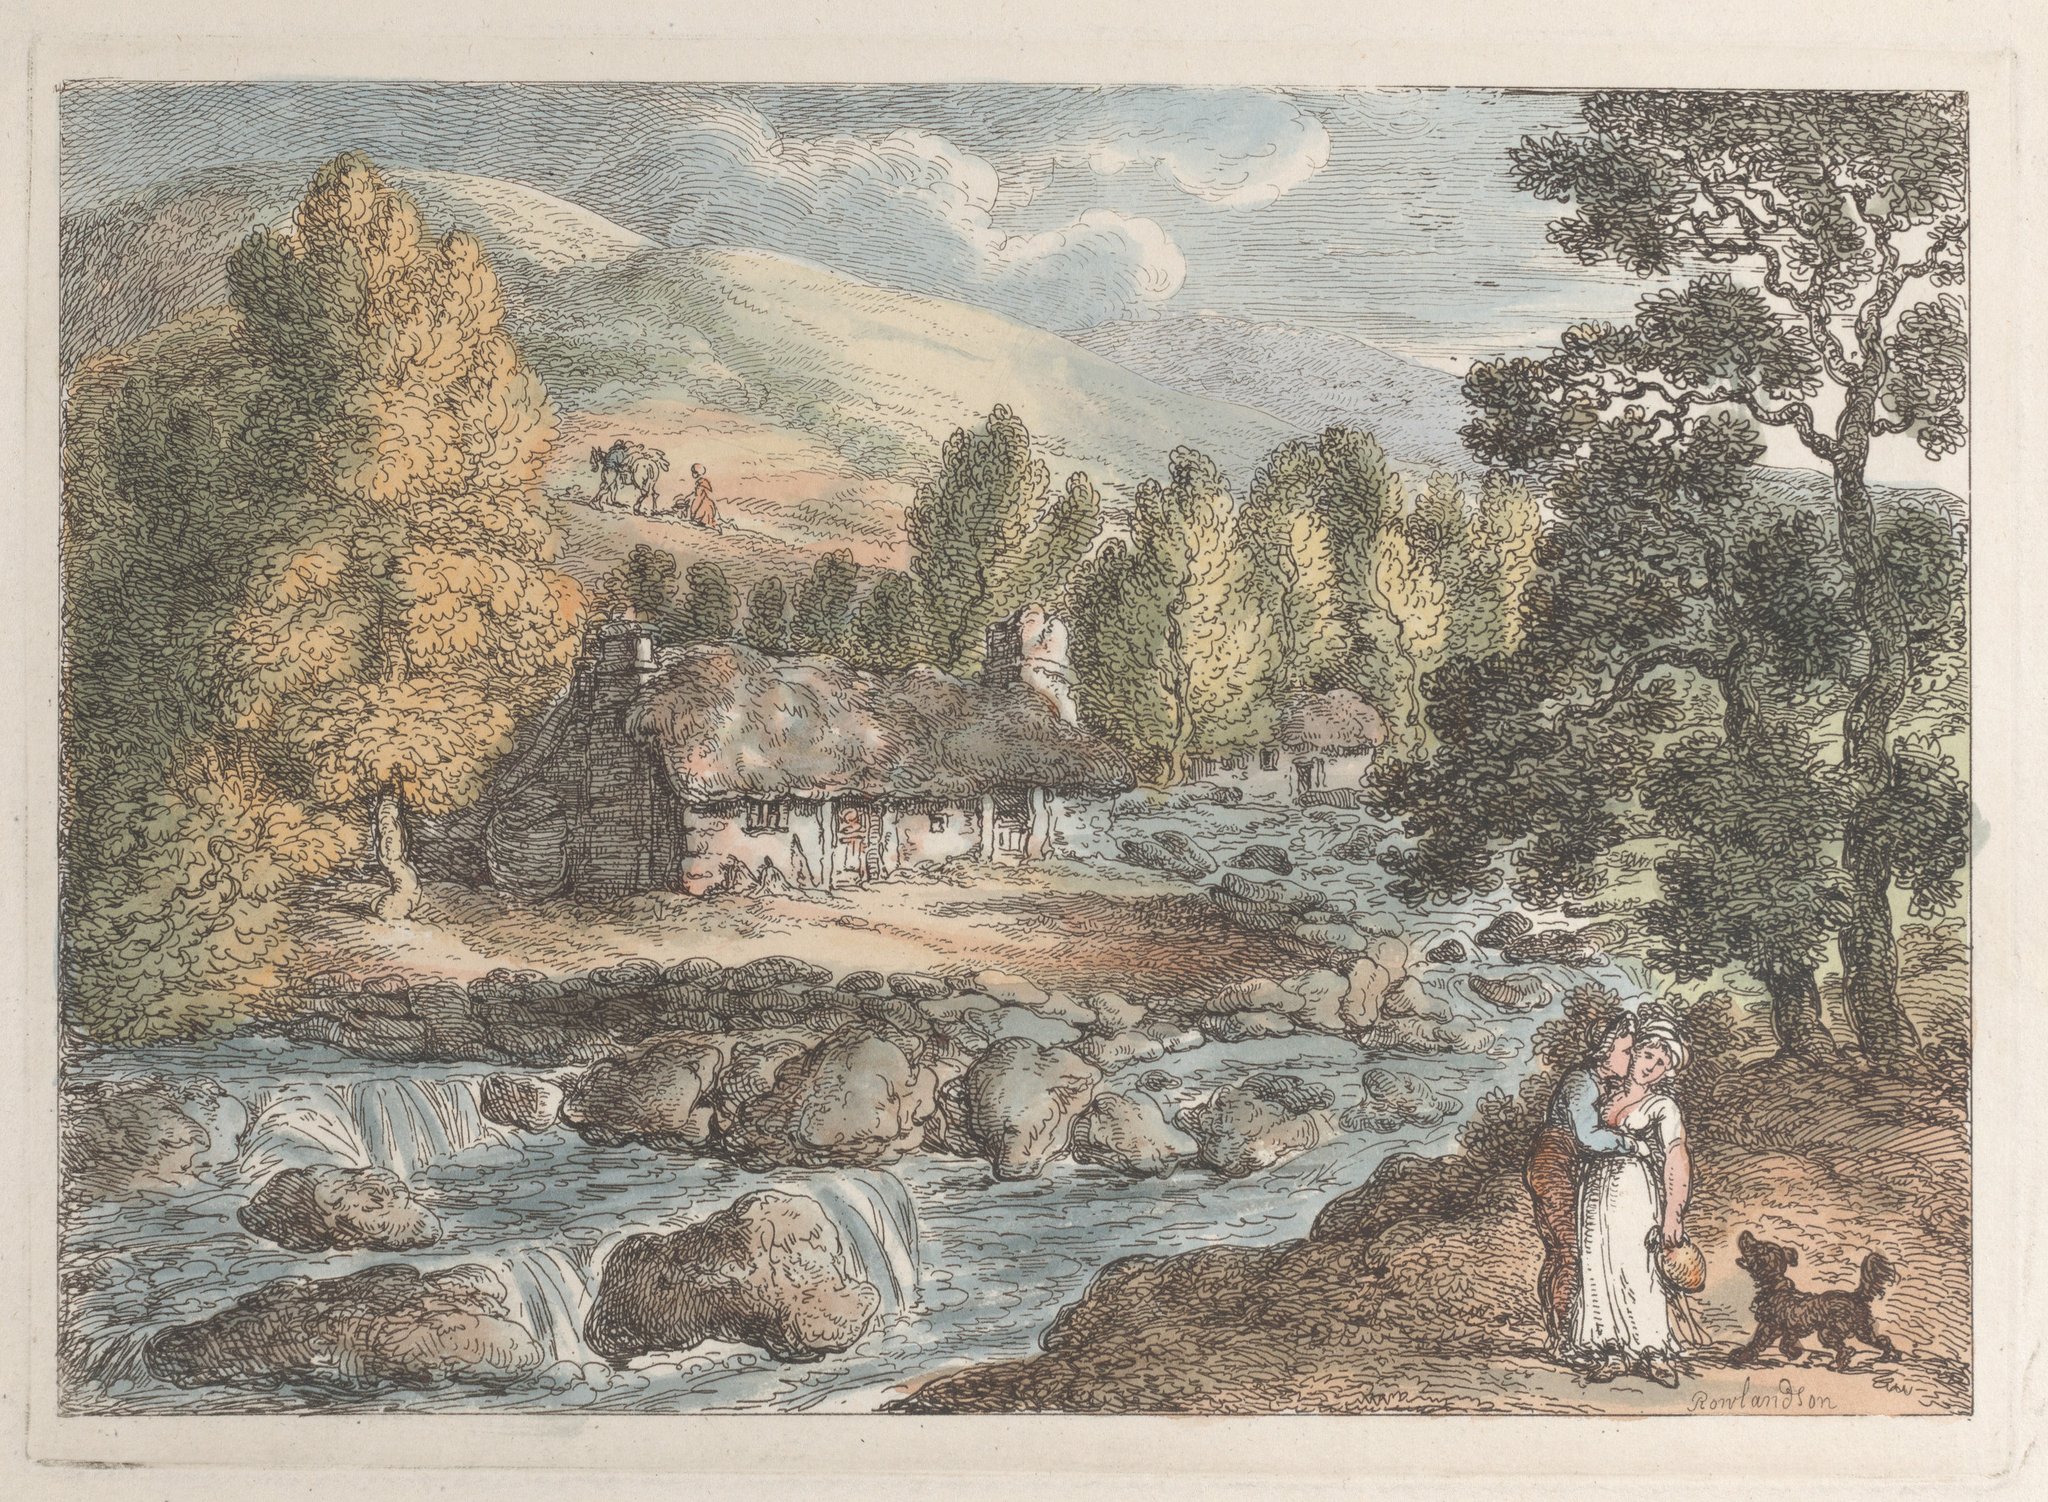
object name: print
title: A Cornish Waterfall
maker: thomas rowlandson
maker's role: artist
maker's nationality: british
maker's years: 1757-1827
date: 1812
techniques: etching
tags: waterfalls,landscapes